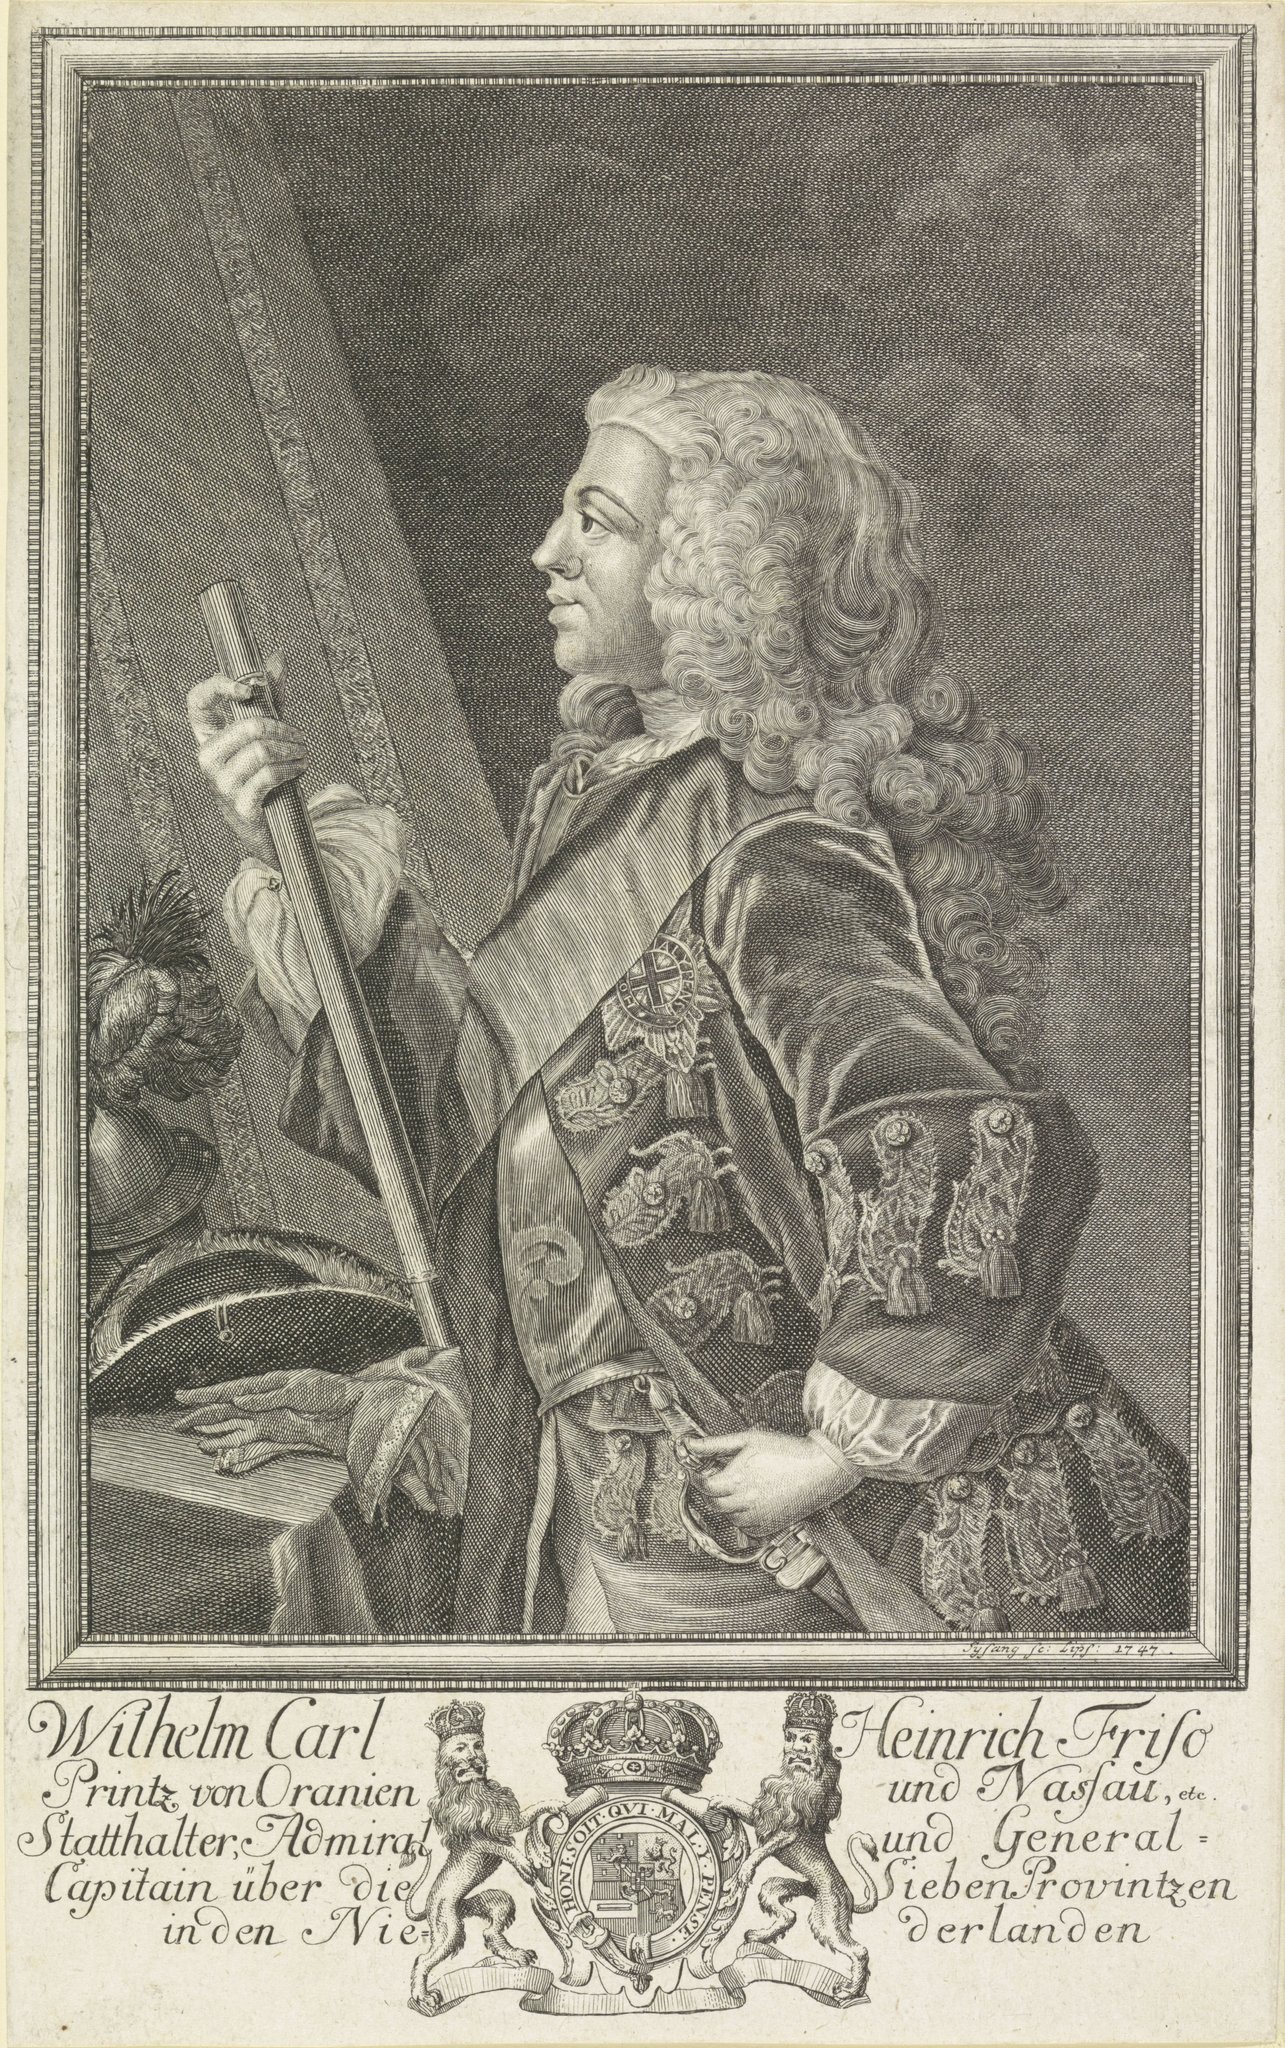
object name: print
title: Portret van Willem IV, prins van Oranje-Nassau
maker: johann christoph sysang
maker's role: print maker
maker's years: 1703-1757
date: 1747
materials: paper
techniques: engraving, etching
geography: leipzig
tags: the hague, willem iv (prins van oranje-nassau), knighthood order (garter) - insignia of a knighthood order, e.g.: badge, chain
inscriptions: collector's mark: Lugt 2228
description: Portret van Willem IV. In zijn rechterhand een commandostaf. Midden onder zijn wapen met een kroon en twee leeuwen, gedecoreerd met de Kousenband en het devies van de Orde van de Kousenband. In de ondermarge zijn naam en titels.